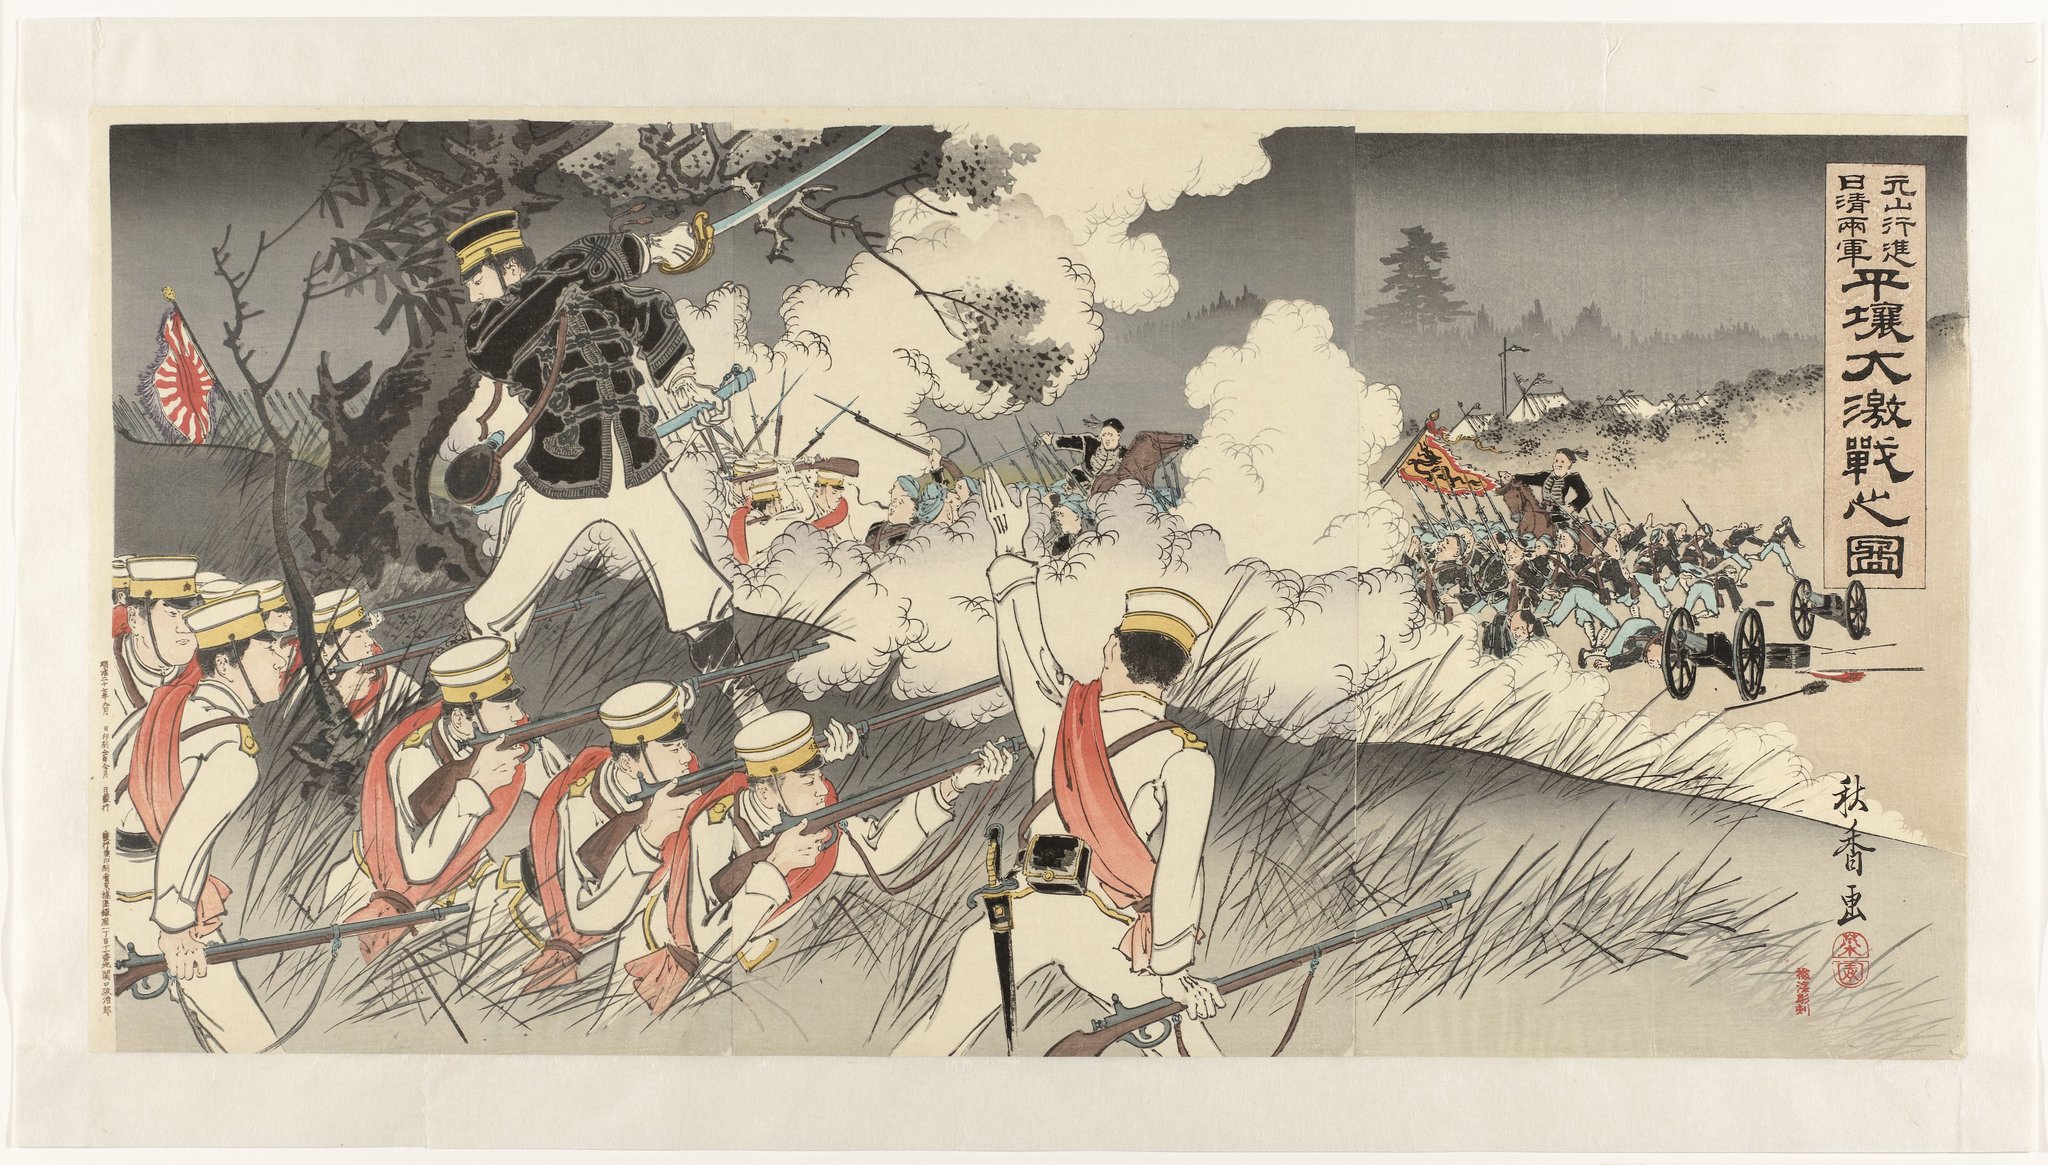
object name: triptych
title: Genzan kôshin Nisshin ryôgun Heijô daigekisen no zu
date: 1894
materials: paper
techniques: woodcut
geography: japan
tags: battle, firearms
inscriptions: label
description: Op 8 augustus 1894 kwam het bataljon van het twaalfde regiment aan bij de haven van Genzan, hun doel was Seoul. Ze werden door de Luitenant-Generaal Nozu teruggestuurd naar Sakyrong ter ondersteuning van een andere brigade. Samen werden ze het Sakryong detachement genoemd en waren de rechterflank in de aanval op Pyongyang.